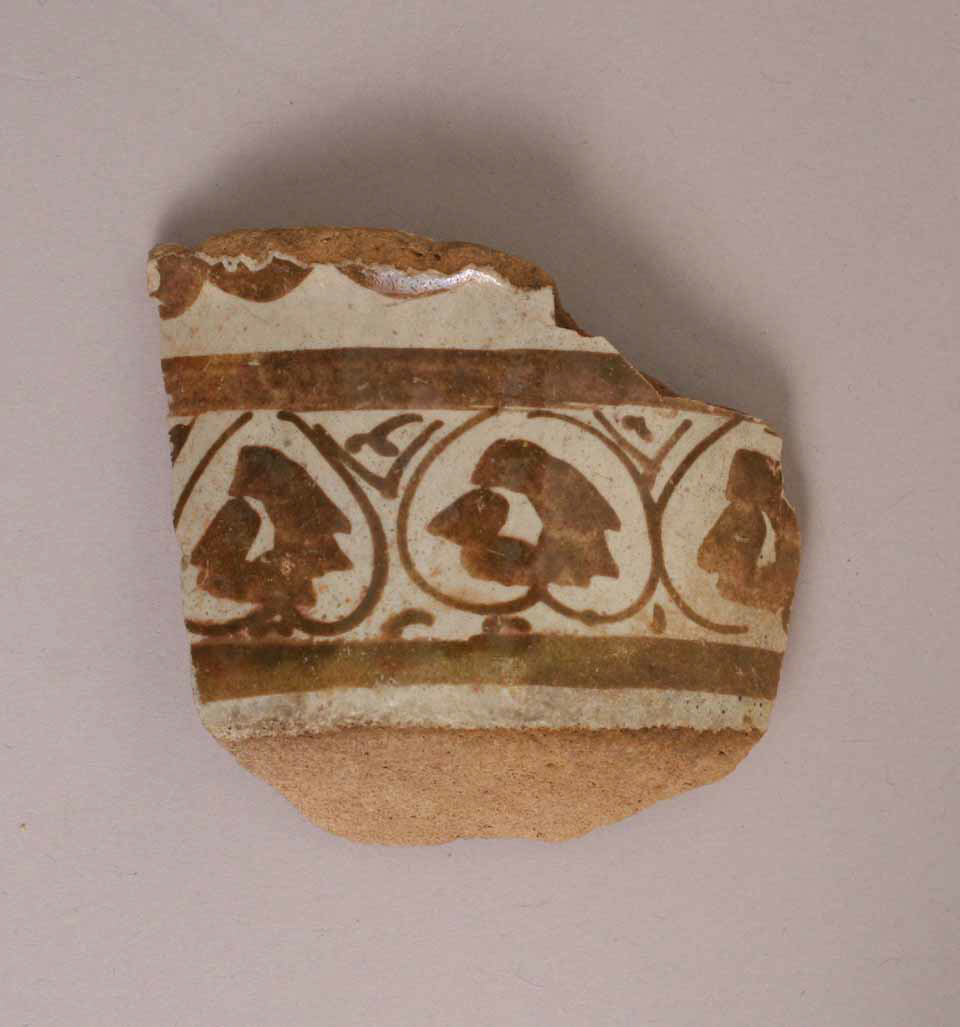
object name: ceramic fragment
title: Fragment of Dish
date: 1001-1200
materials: stonepaste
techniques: glazing, luster painting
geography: syria